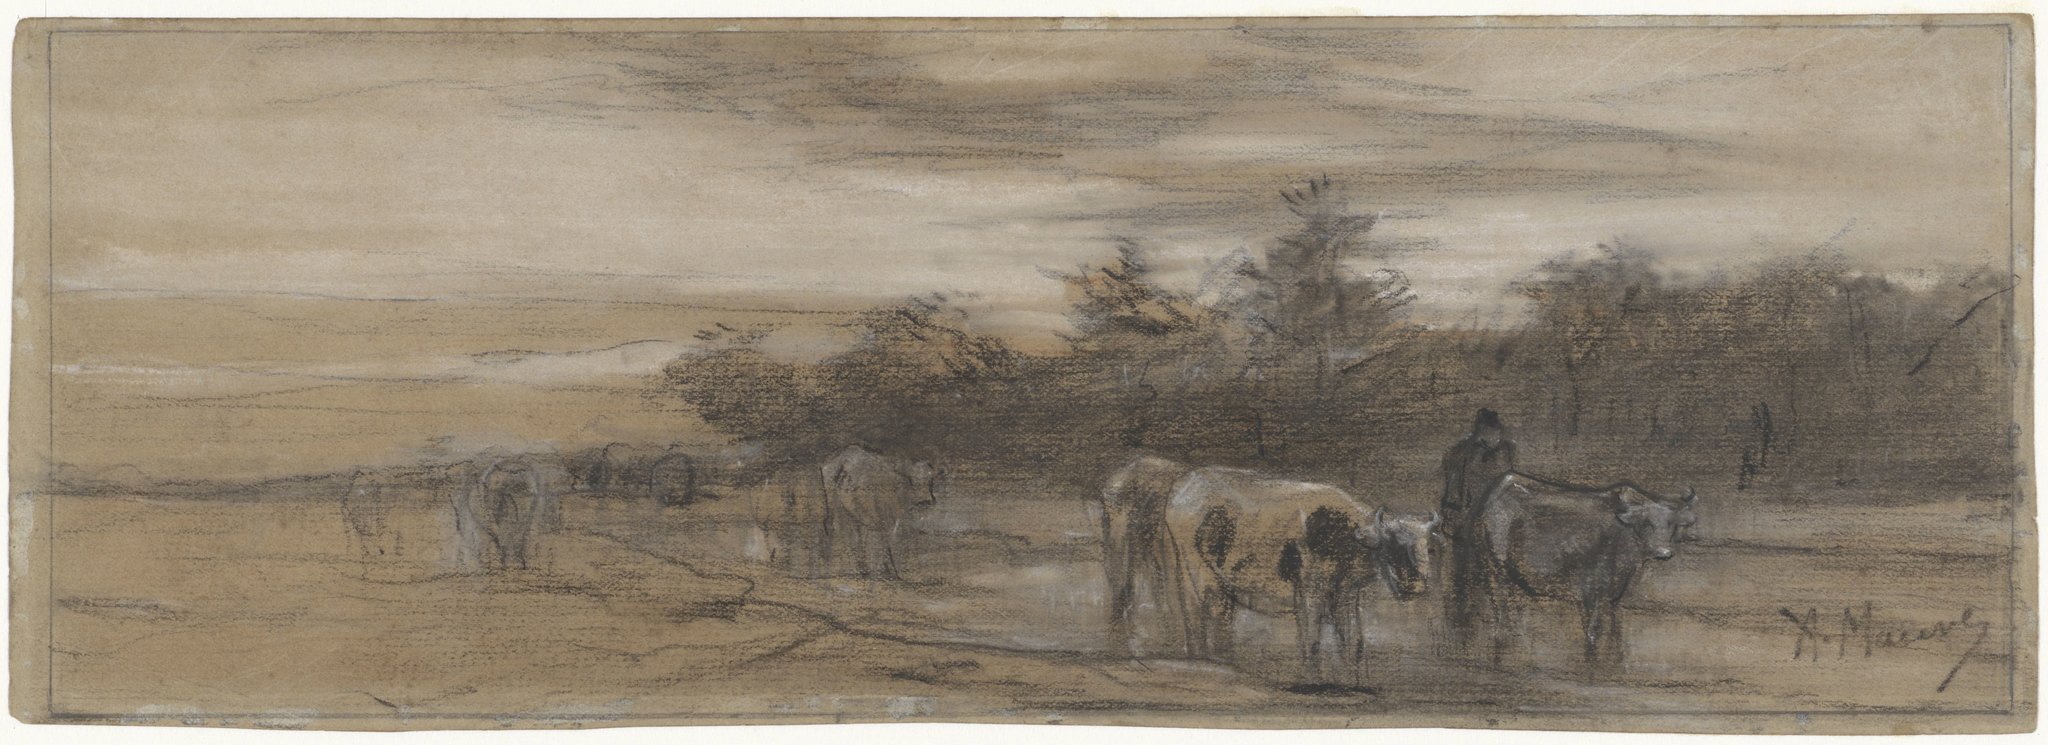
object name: drawing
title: Koeien bij avond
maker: anton mauve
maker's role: draughtsman, painter, print maker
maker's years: 1838-1888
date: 1848-1888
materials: chalk, paper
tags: cow